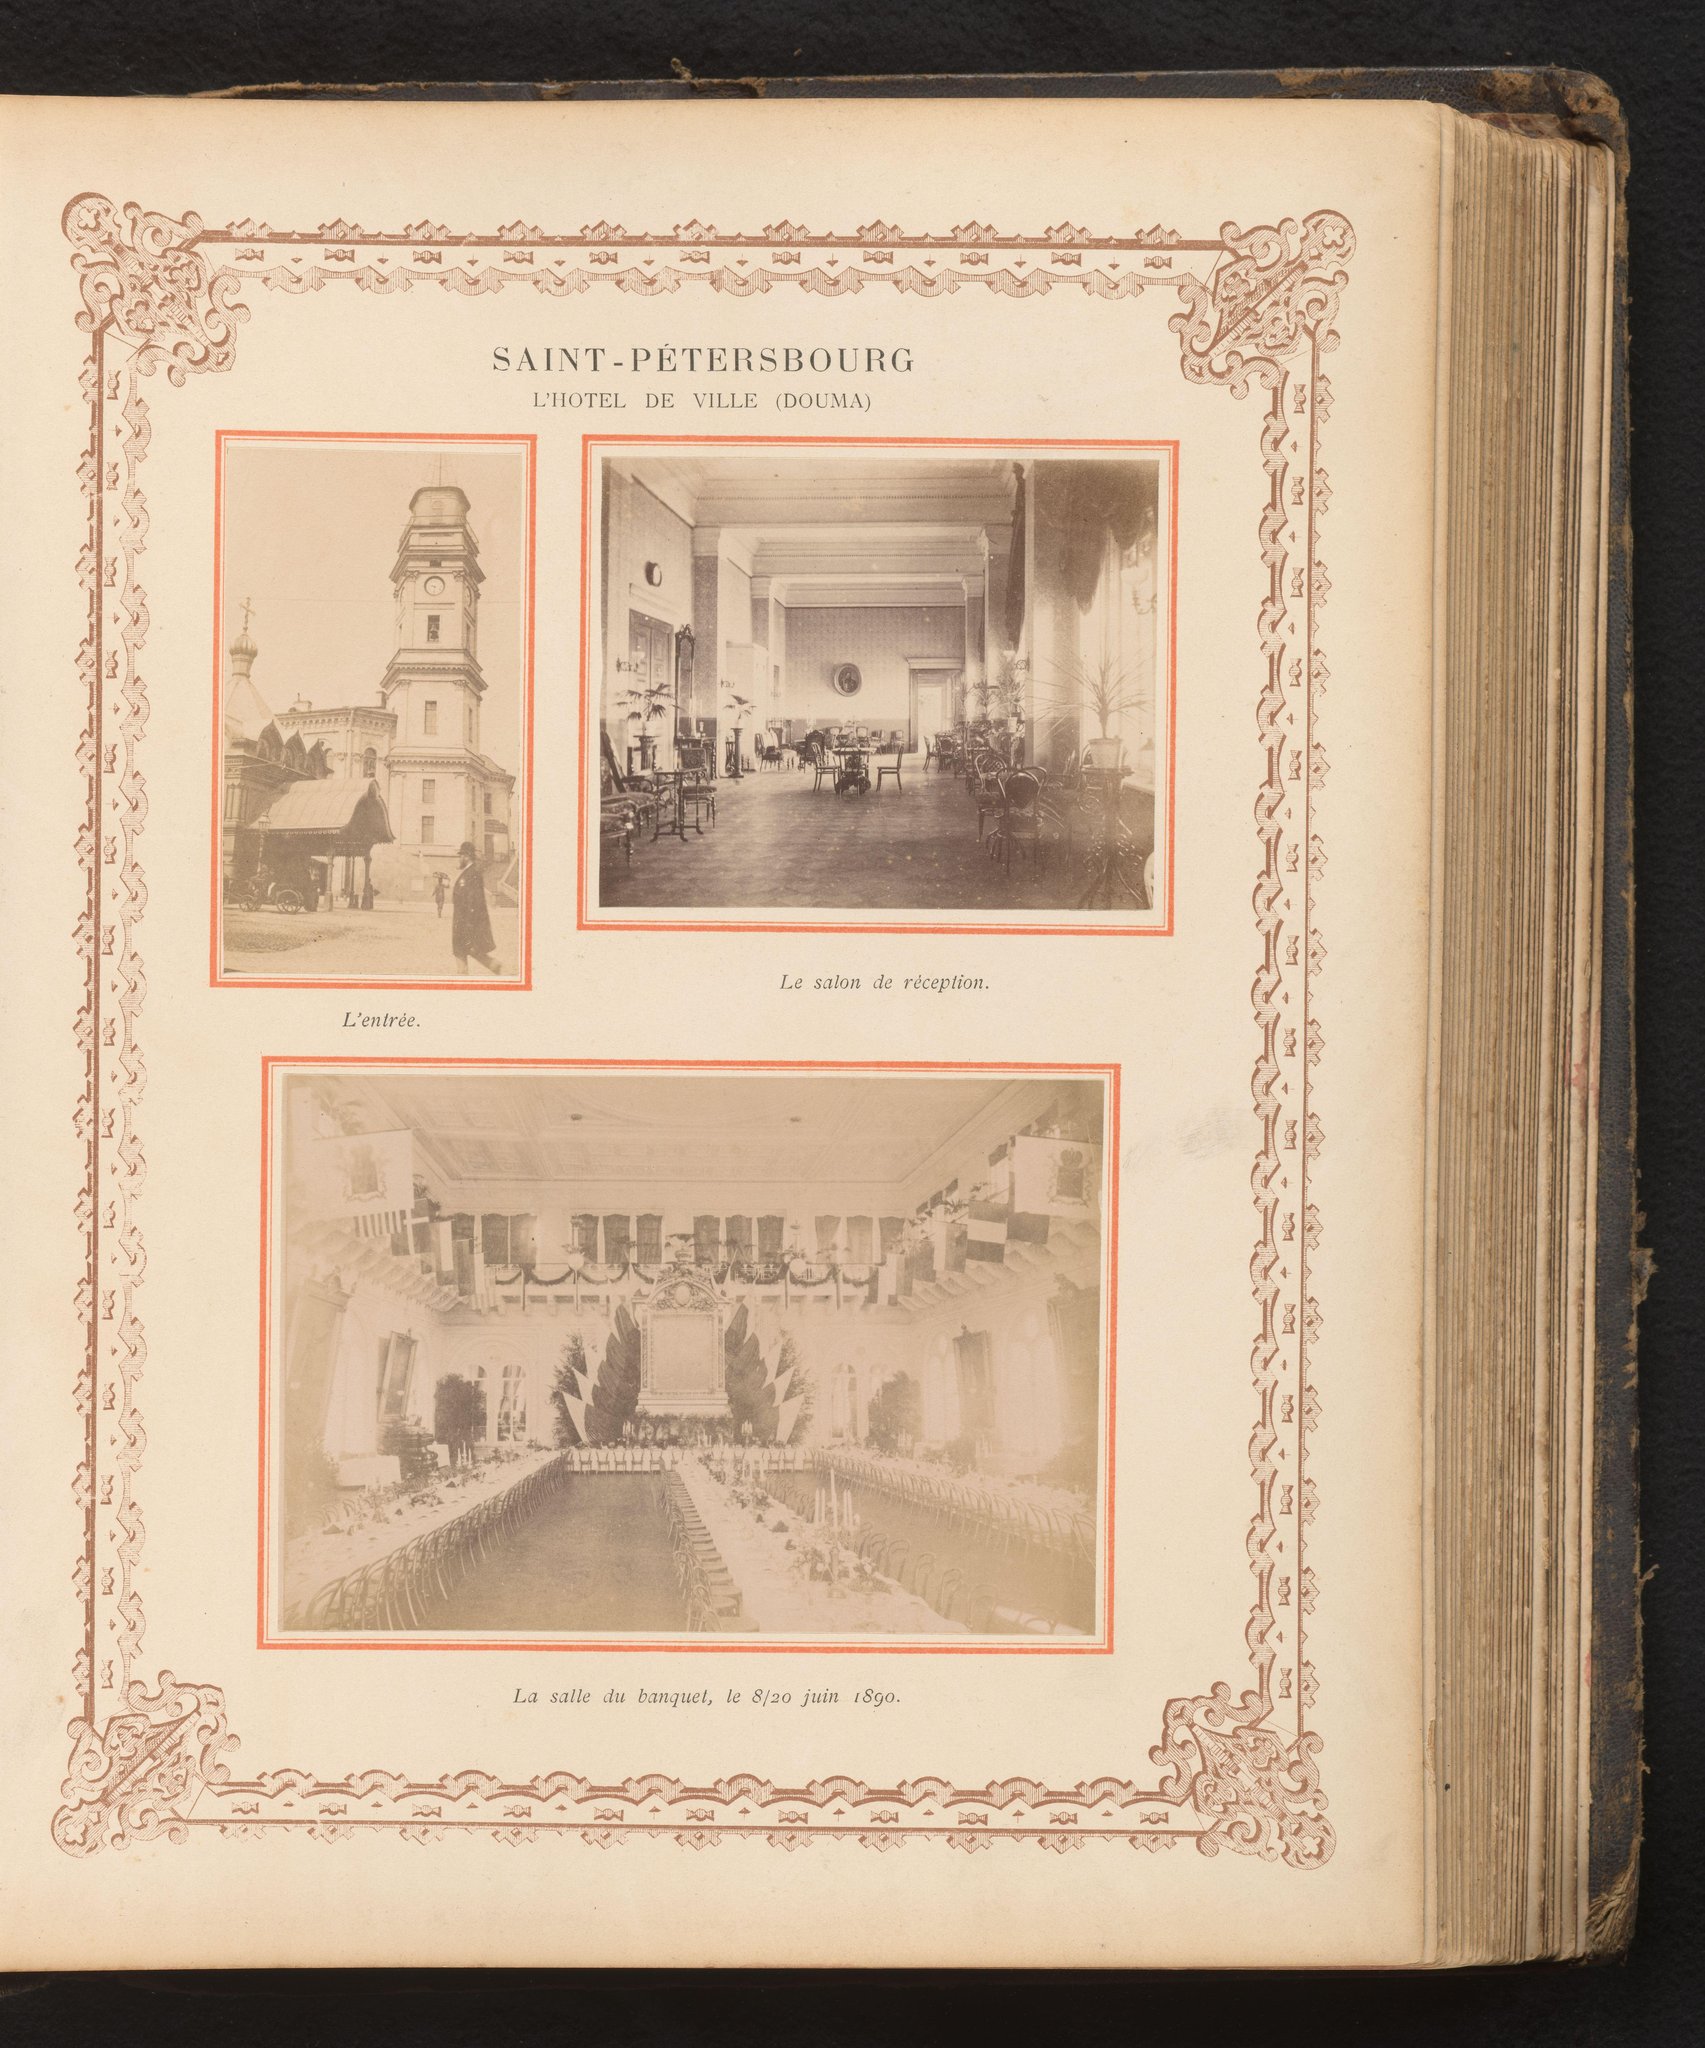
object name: photograph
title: Le salon de réception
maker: Anonymous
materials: photographic support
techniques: albumen print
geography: sint-petersburg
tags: assembly-room, gate, entrance, dining-room